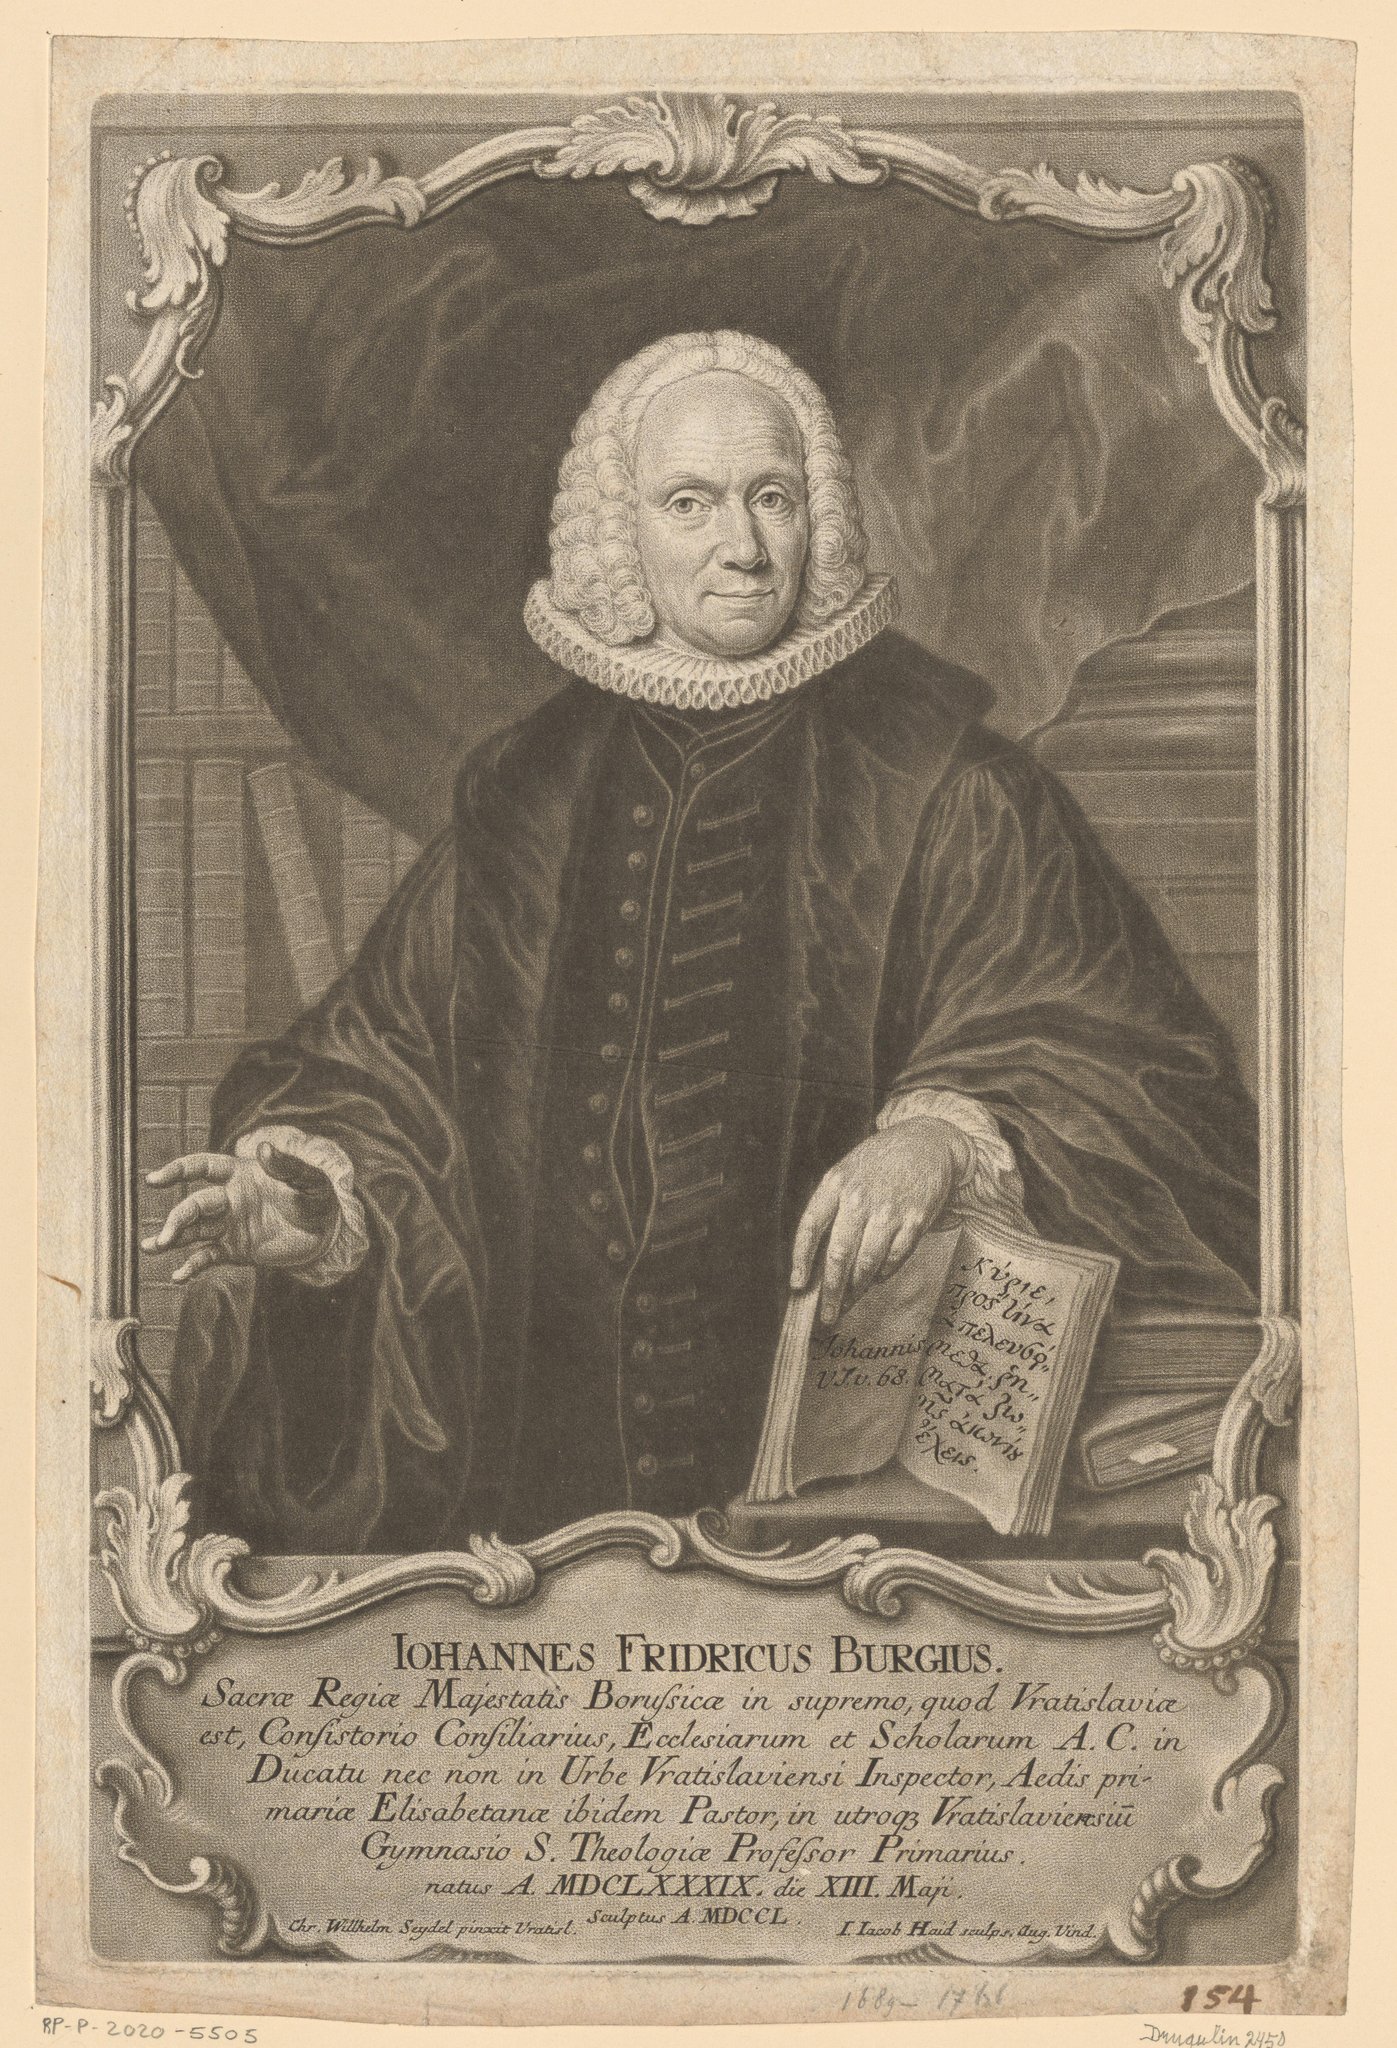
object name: print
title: Portret van Johann Friedrich Burg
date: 1750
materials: paper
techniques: engraving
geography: augsburg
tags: johann friedrich burg, theologian, historical persons, book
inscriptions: date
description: Prent waarschijnlijk uit: Brucker, Jacob. Bilder-sal heutiges Tages lebender und durch Gelahrtheit berühmter Schrifft-steller (...). Augsburg: Johann Jacob Haid, 1750, dl. 8.